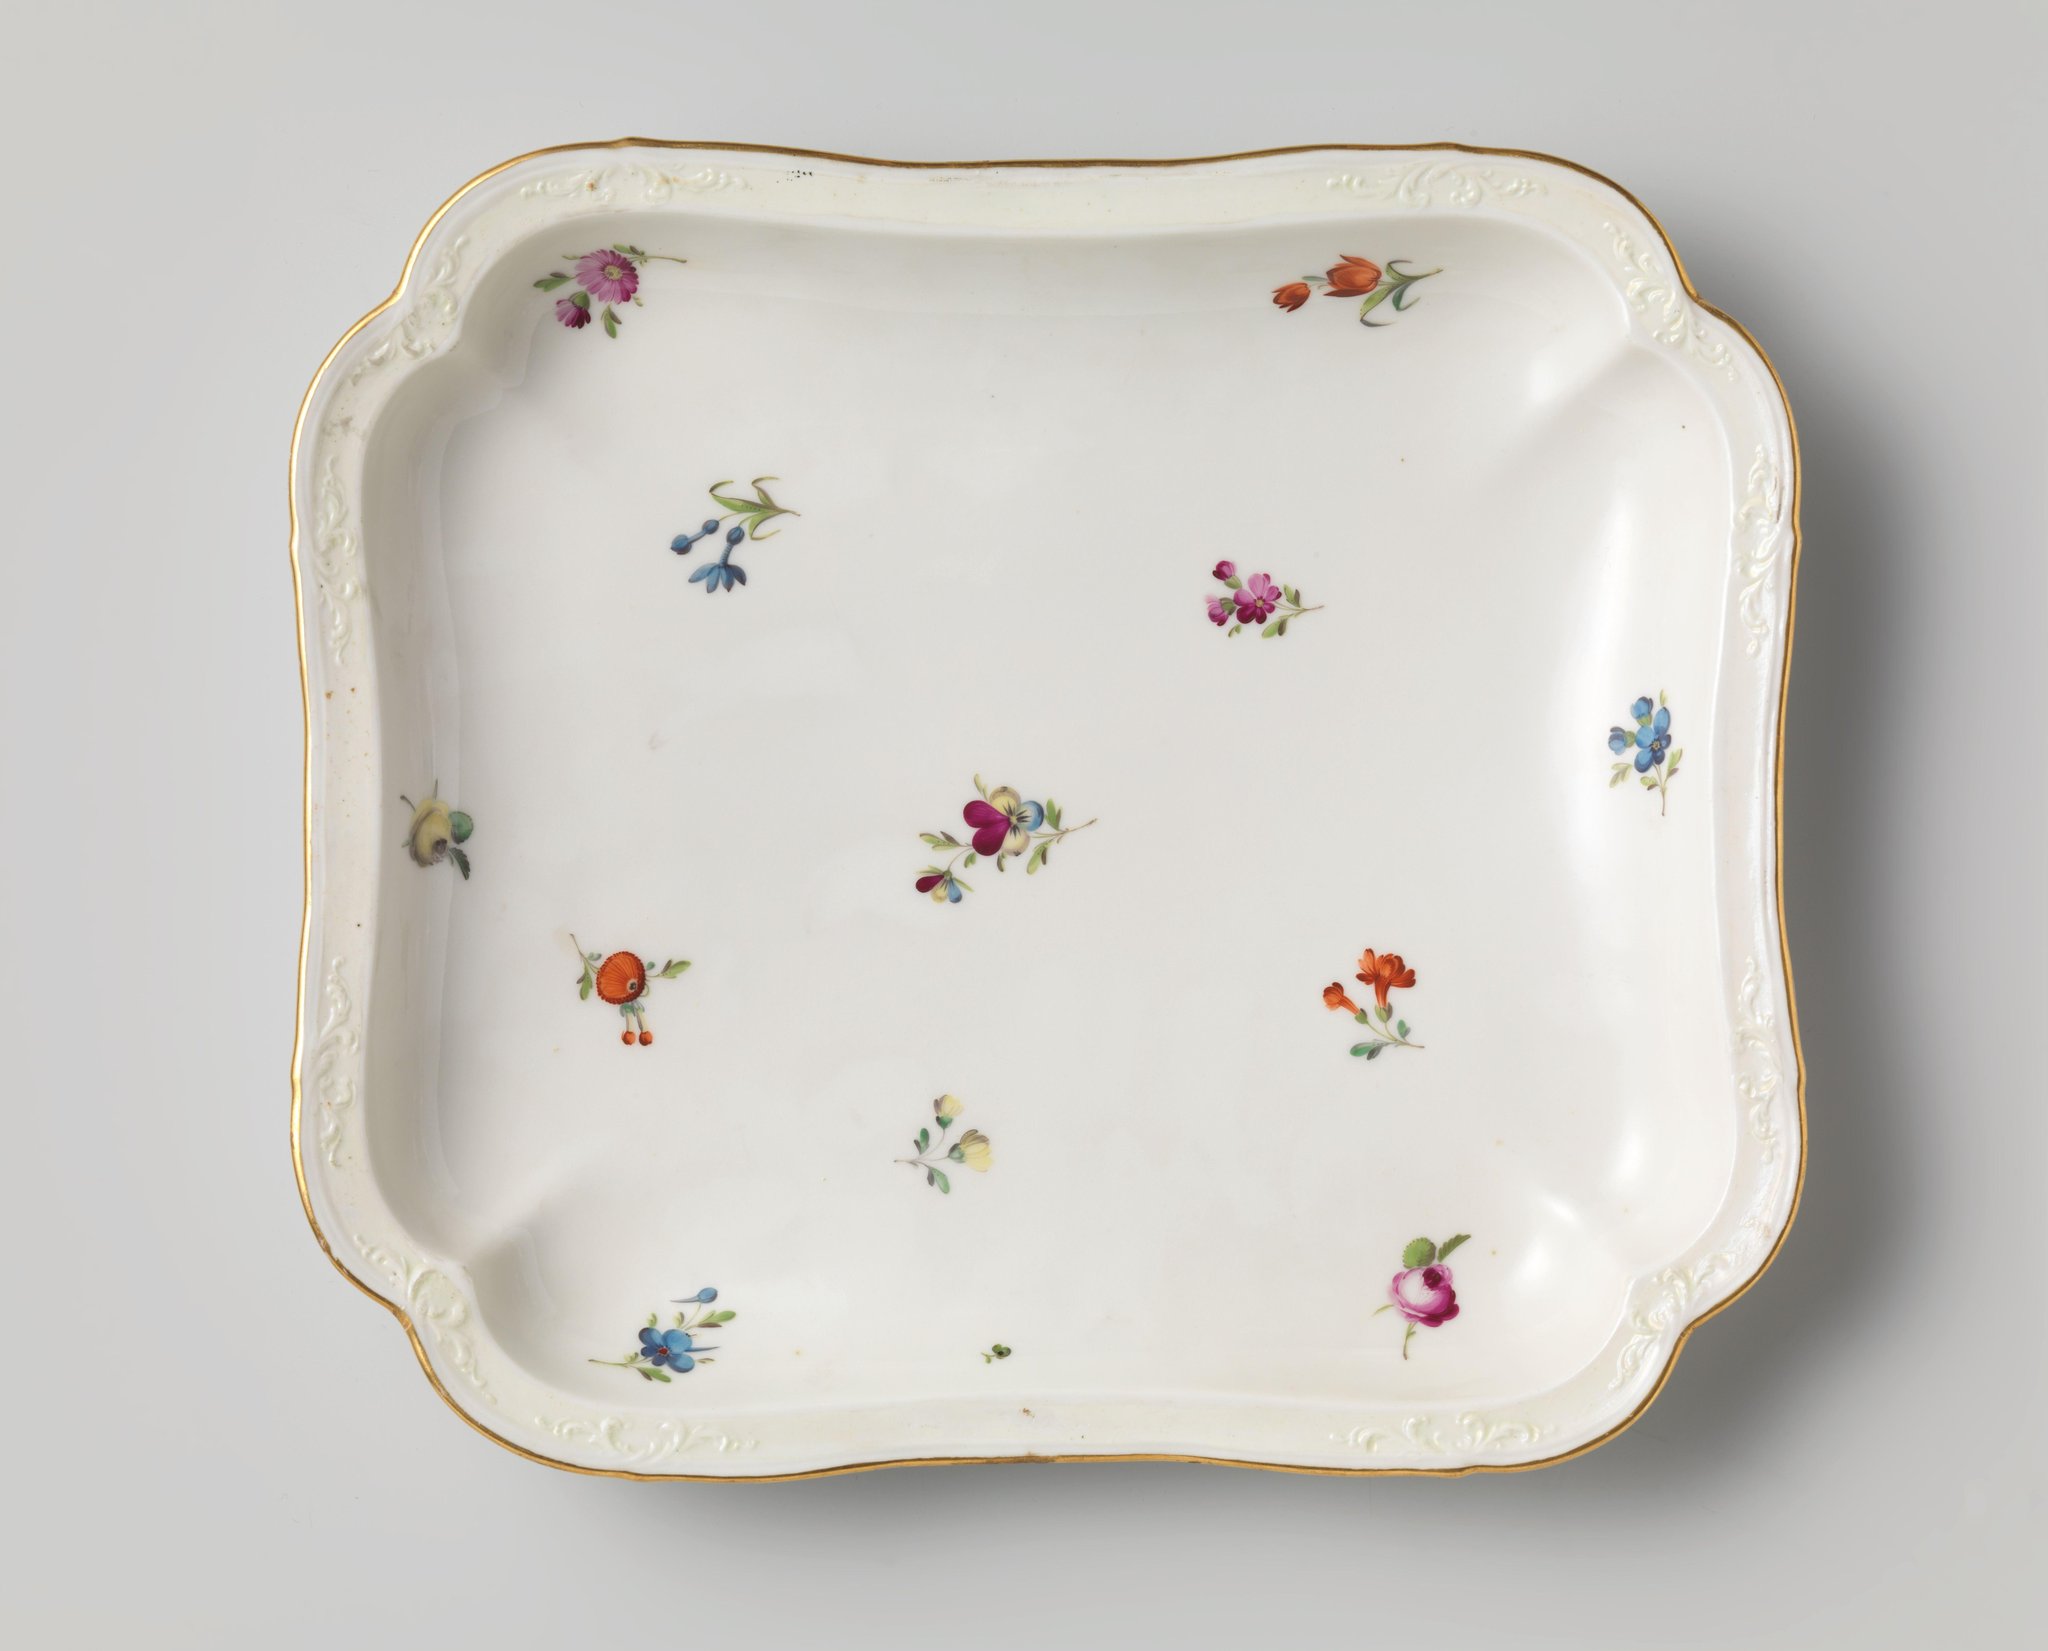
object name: dish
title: Schaal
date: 1784-1814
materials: porcelain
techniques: painted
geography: amstel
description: Vierkante schaal met ingesnoerde hoeken, veelkleurig beschilderd met strooibloemen. Gemerkt: Amstel.